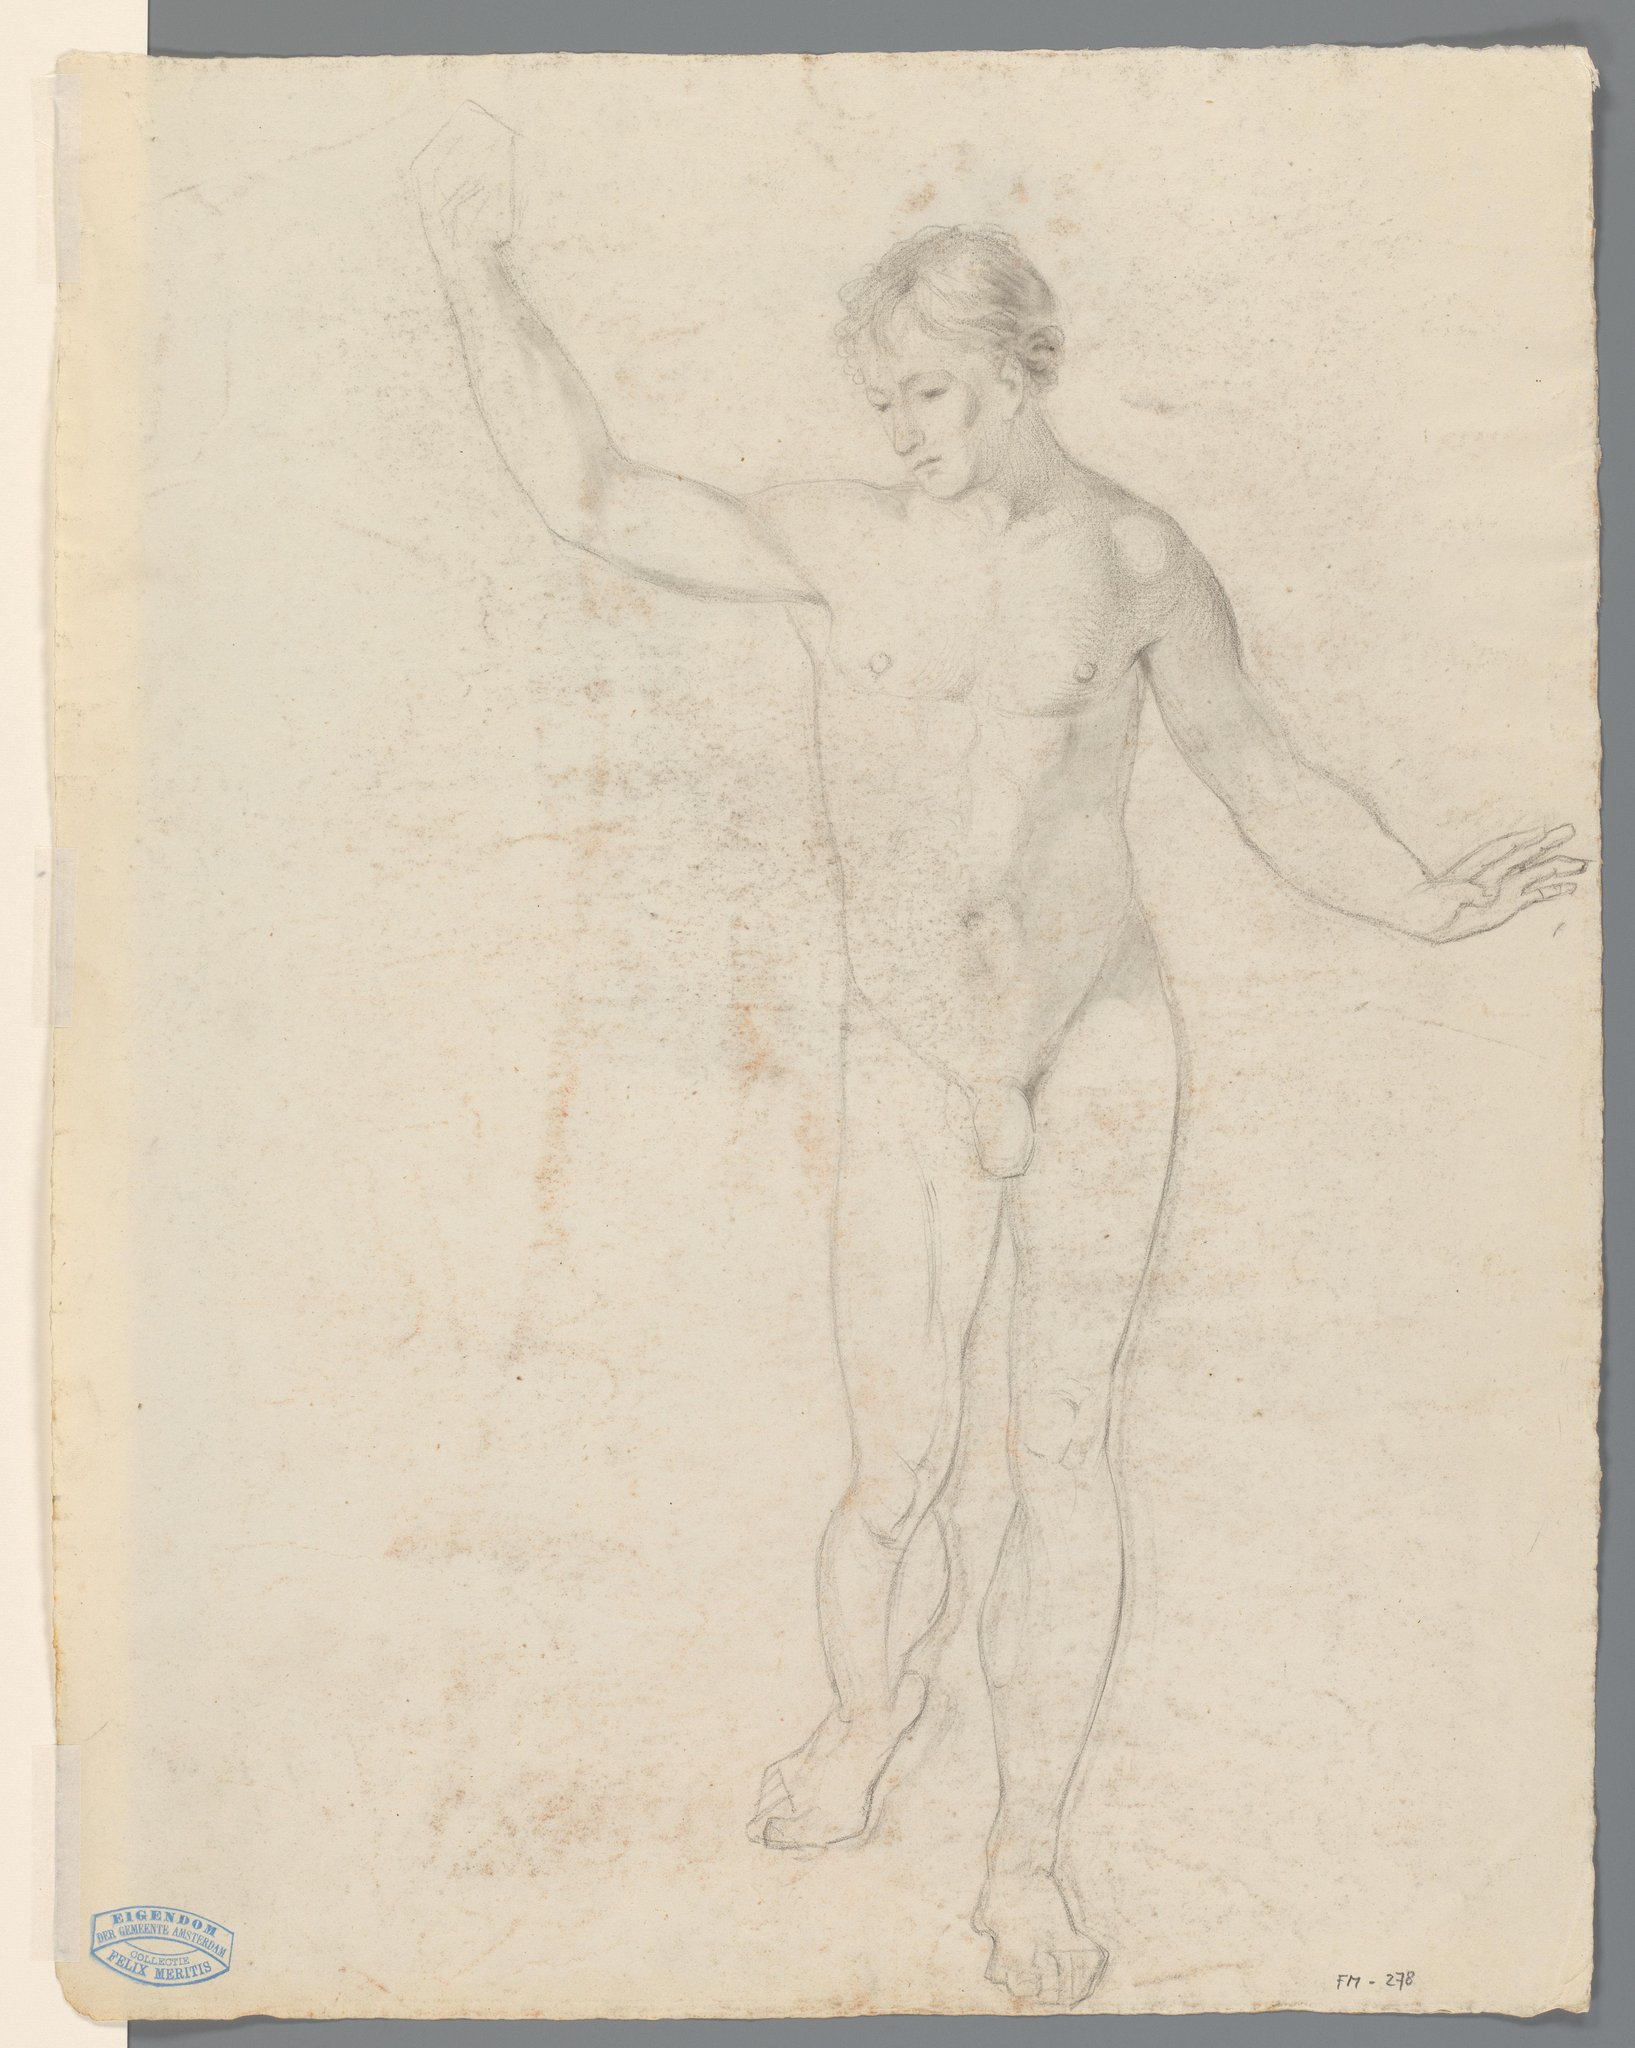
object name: drawing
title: Staand mannelijk naakt, van voren gezien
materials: chalk, paper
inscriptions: date: ‘3 febr. 1812’